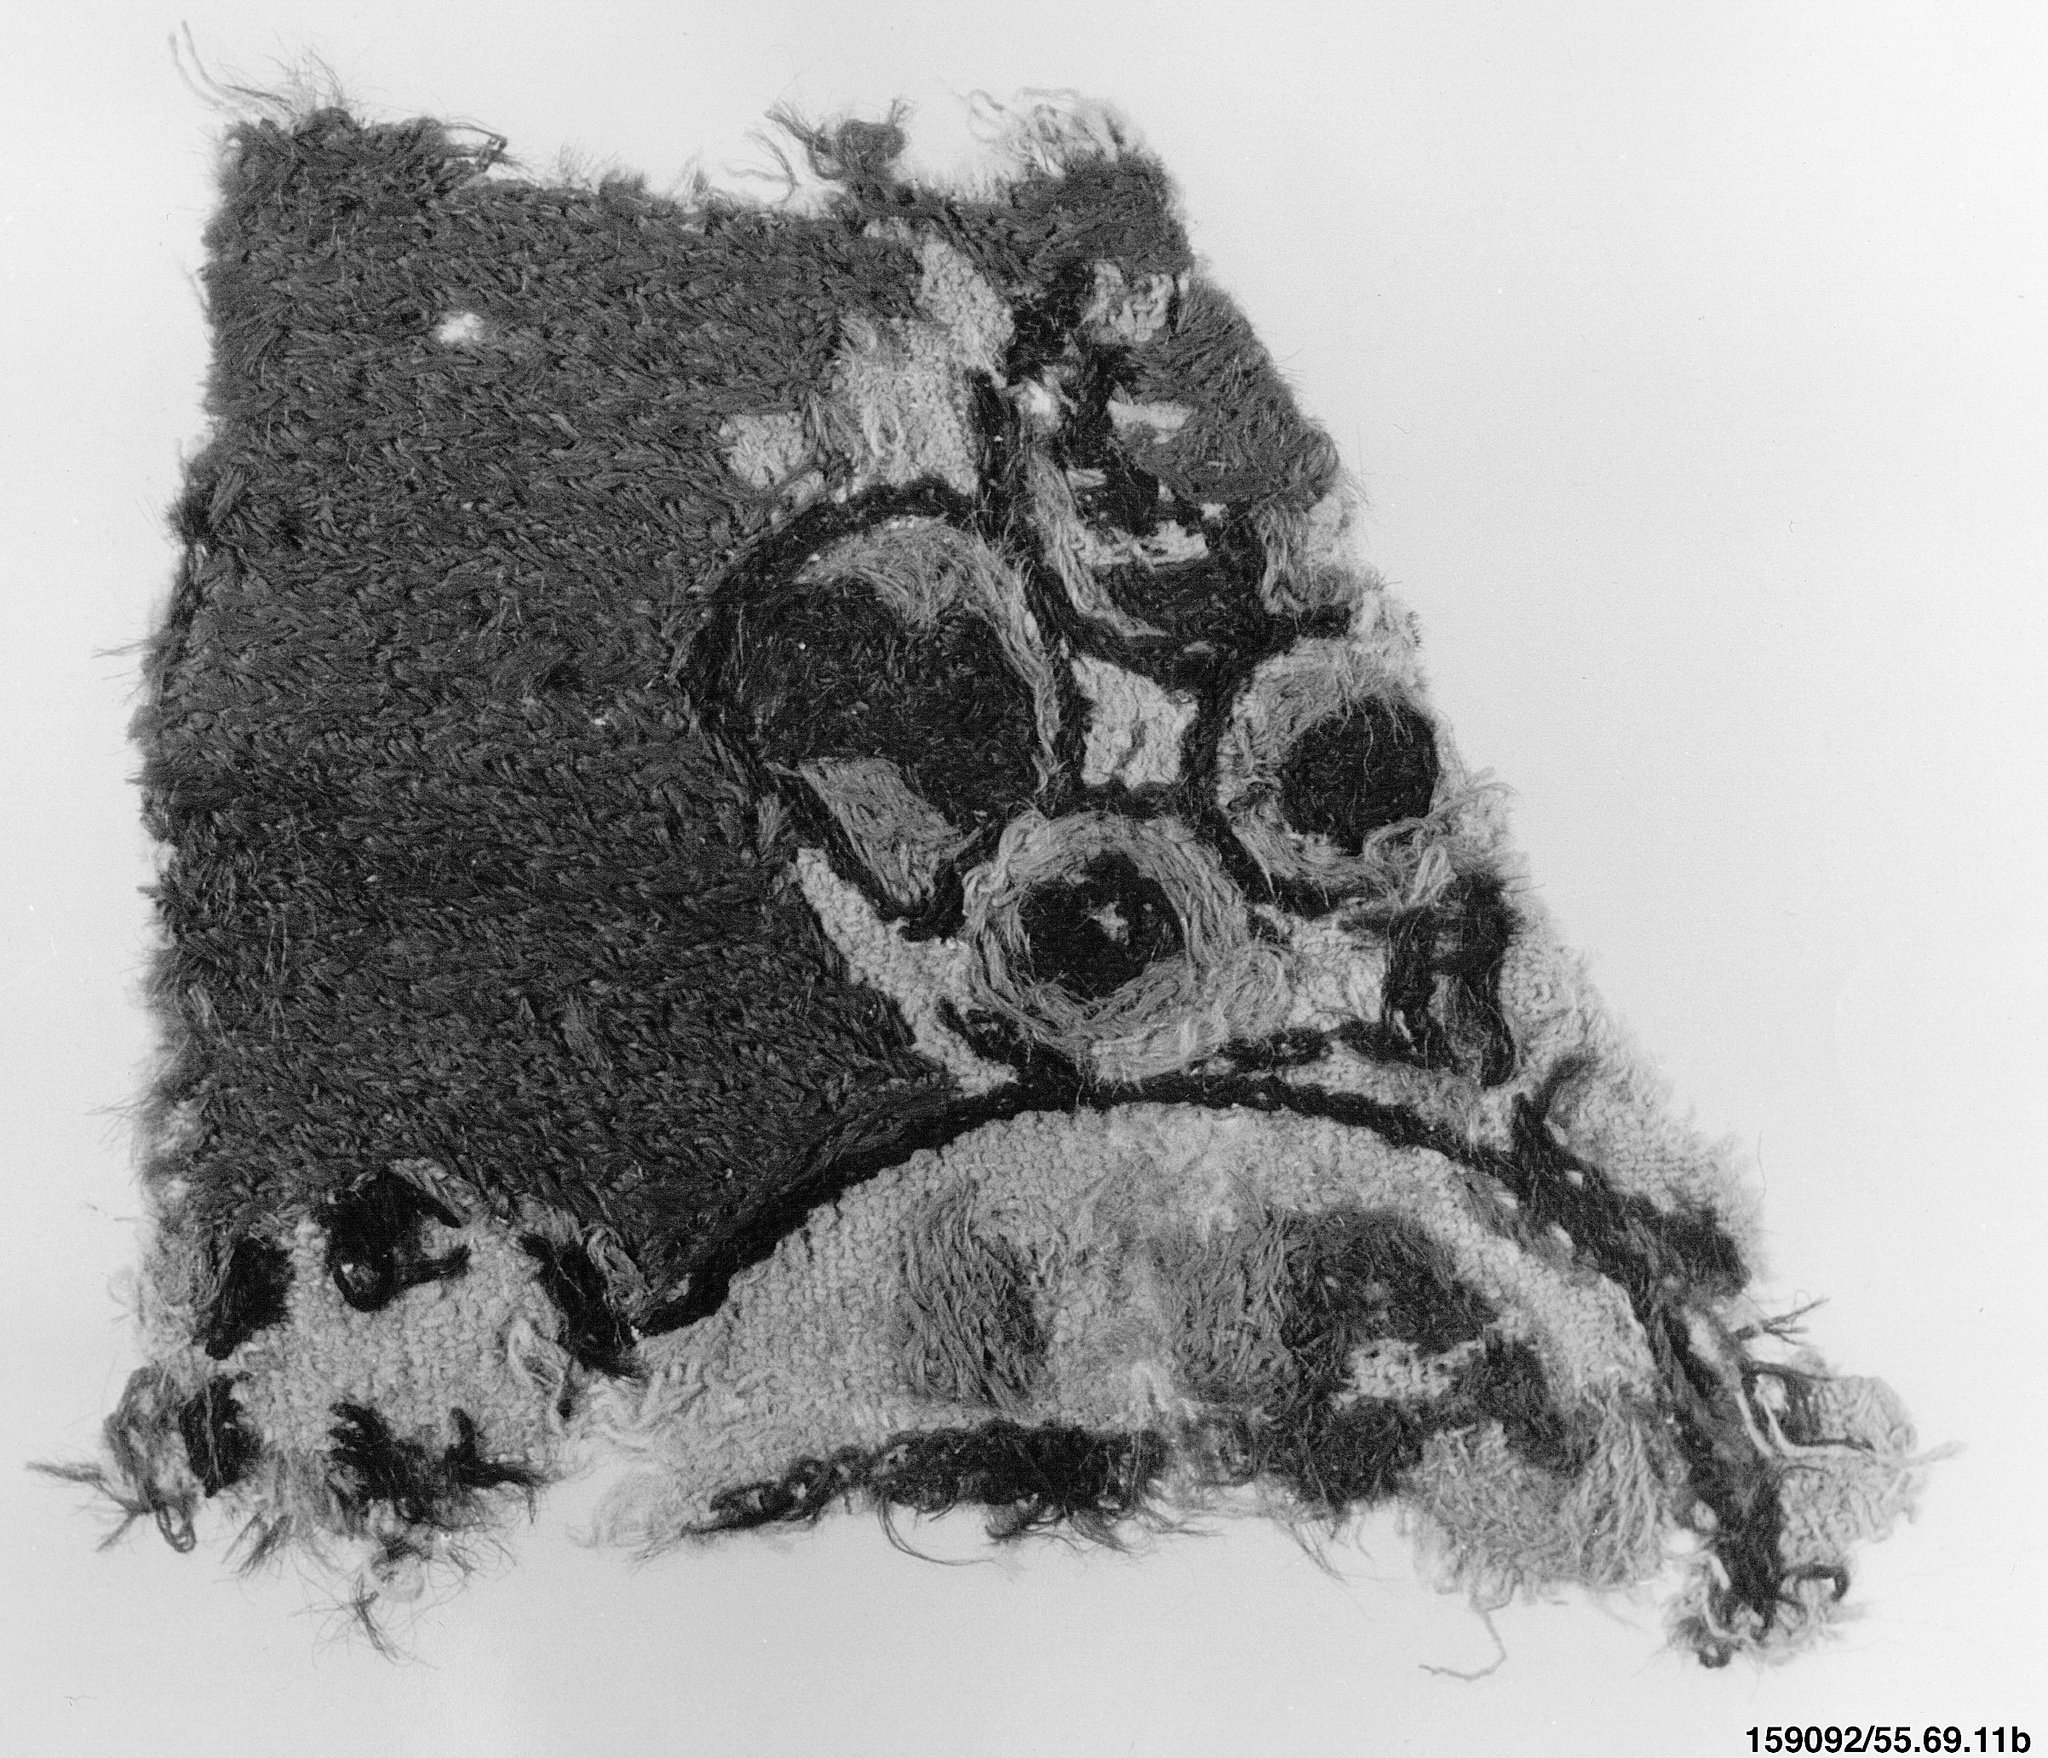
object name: textile fragment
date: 701-900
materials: wool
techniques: embroidery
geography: egypt